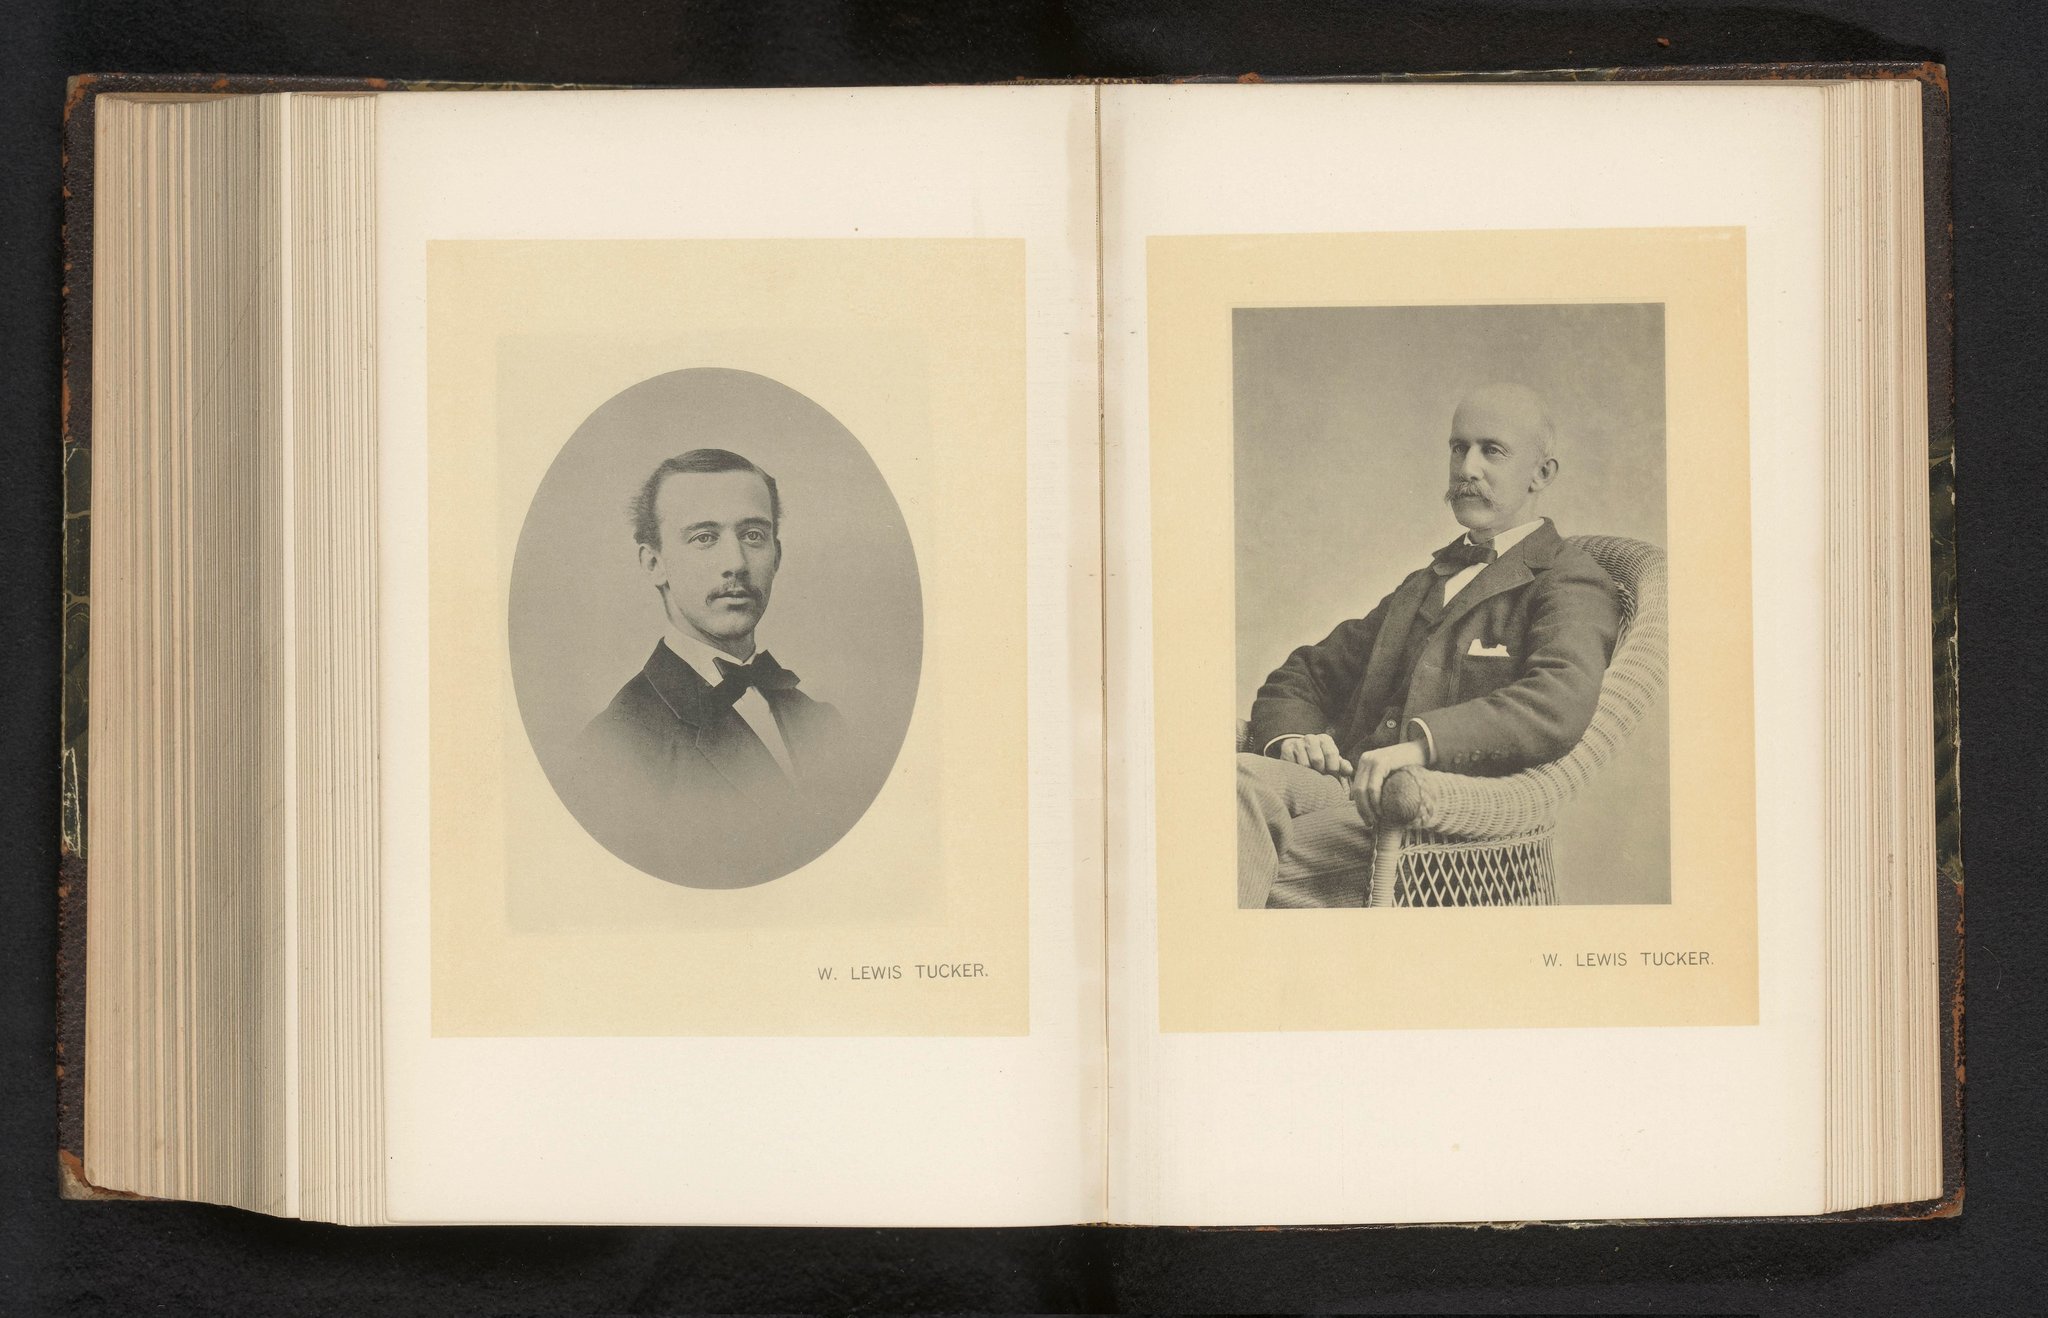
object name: page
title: W. Lewis Tucker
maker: Anonymous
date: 1889-1894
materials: paper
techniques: photoaquatint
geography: boston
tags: adult man